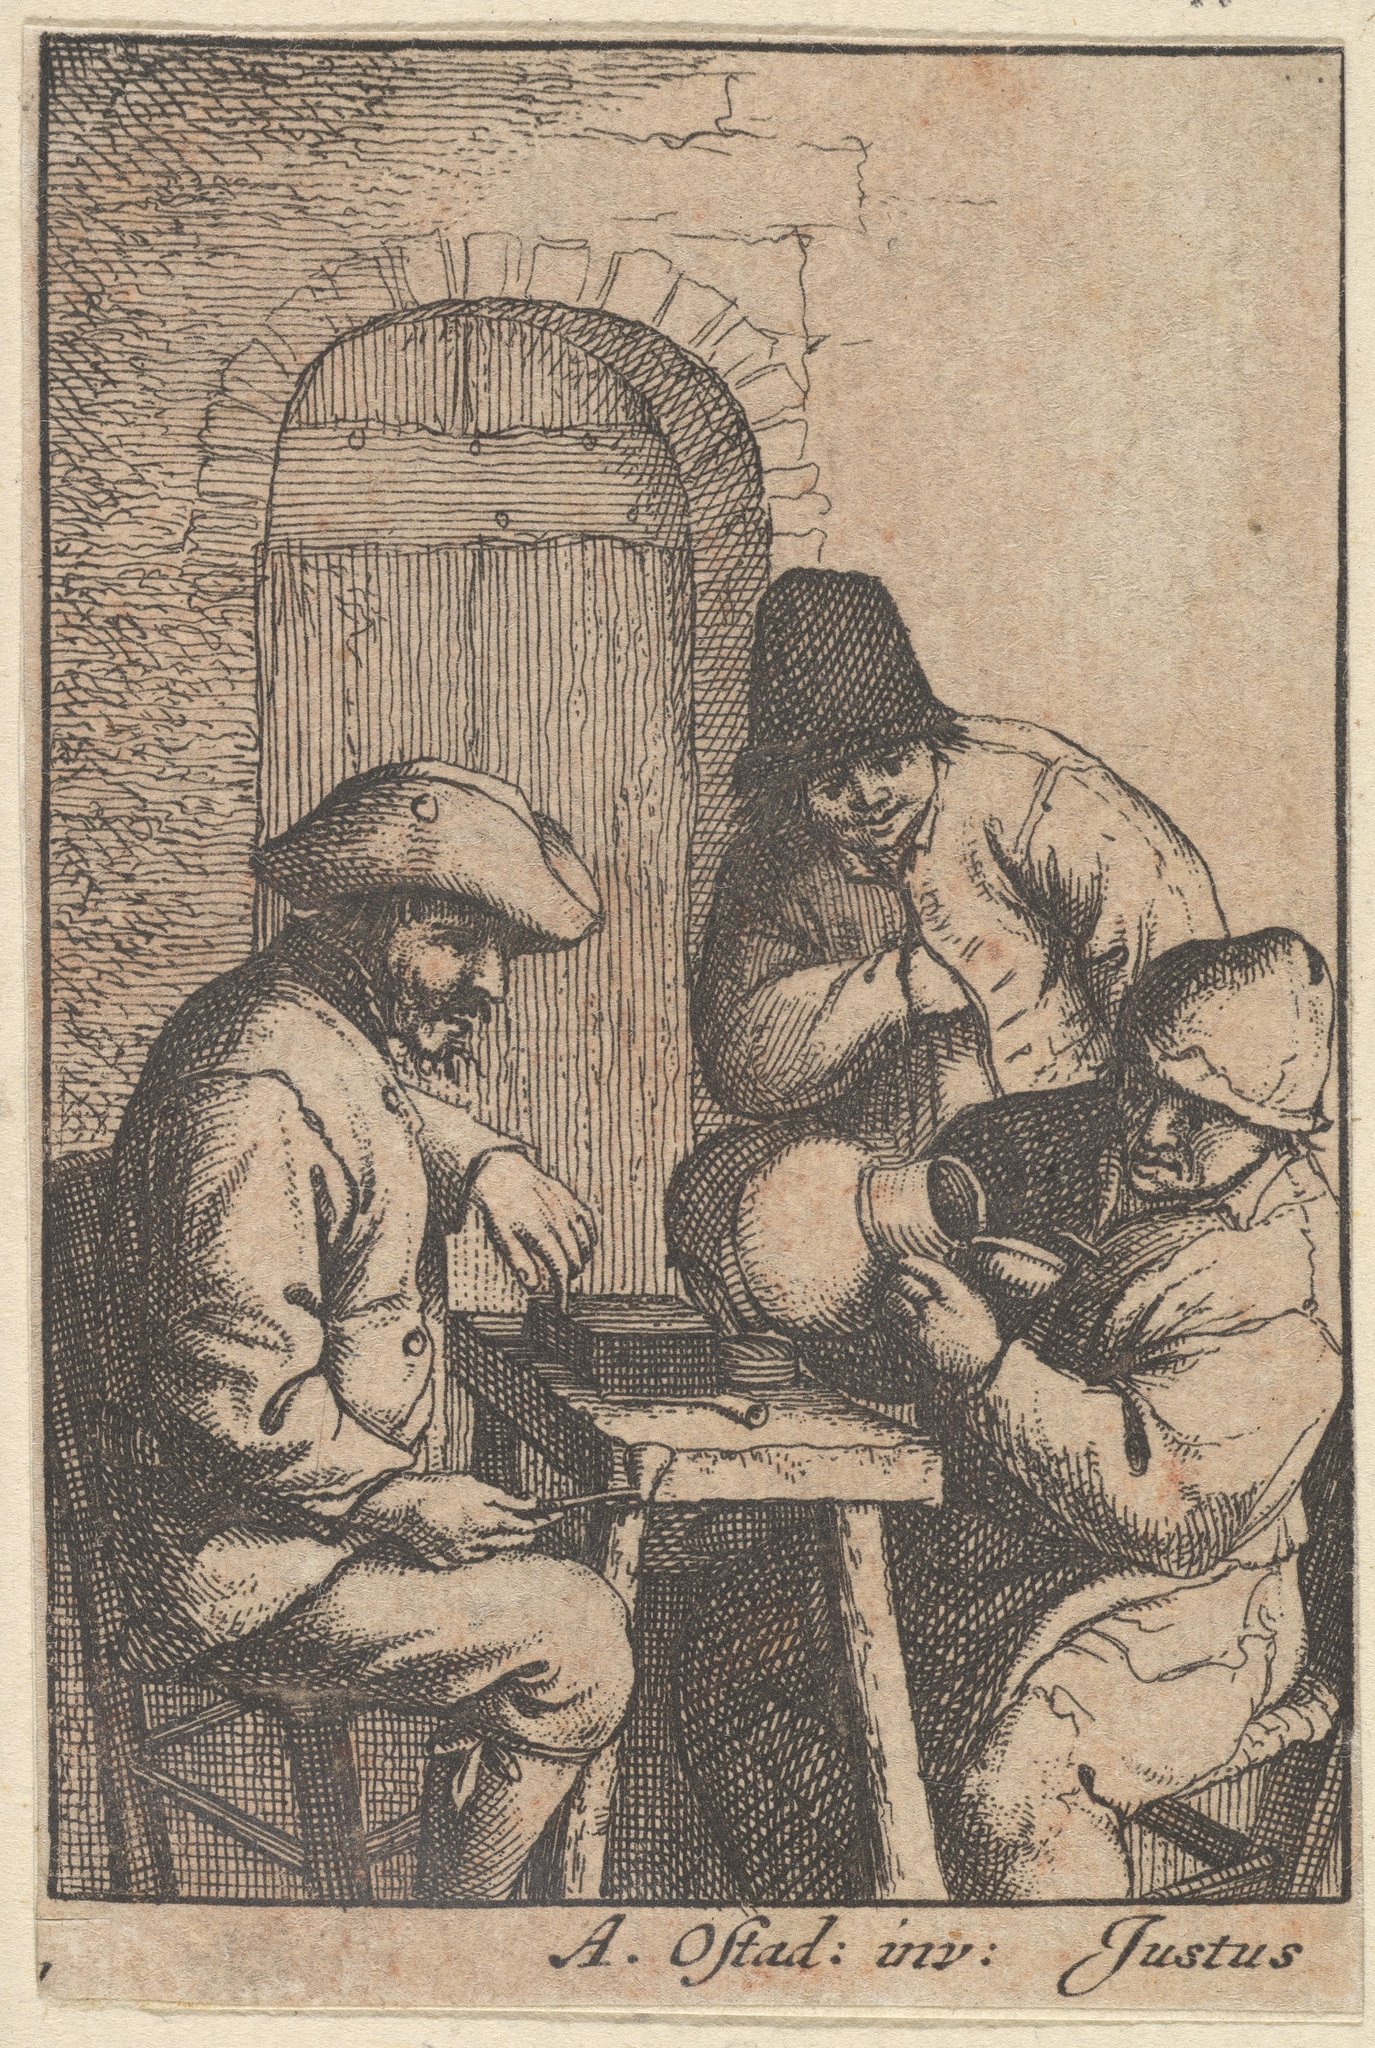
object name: print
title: Empty Jug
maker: adriaen van ostade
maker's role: artist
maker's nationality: dutch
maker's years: 1610-1685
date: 1610-1685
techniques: etching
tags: men,jugs